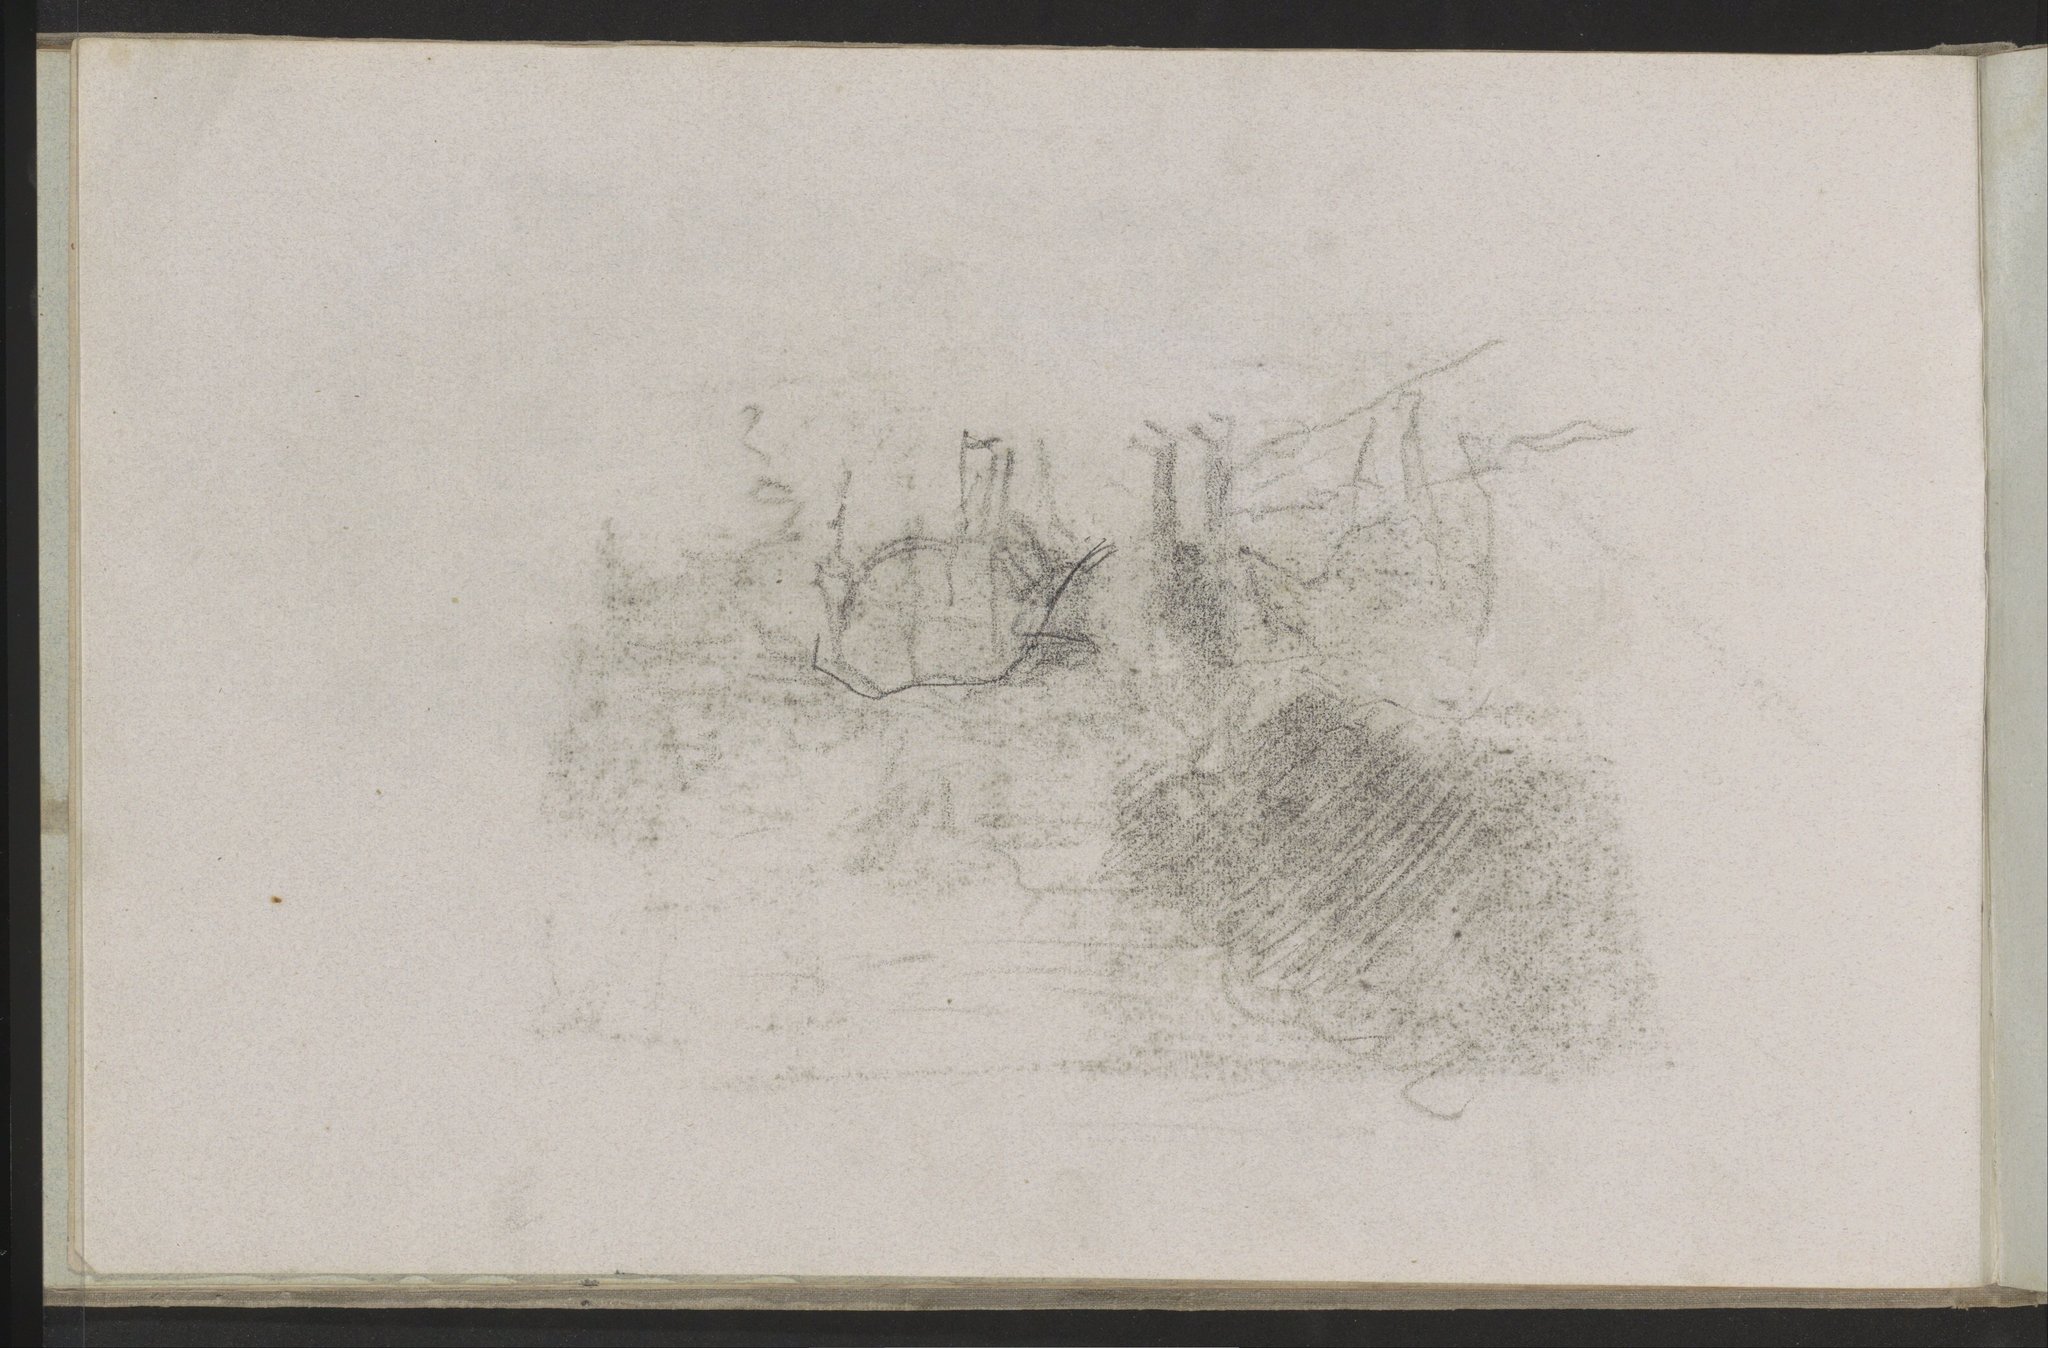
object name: sketchbook leaf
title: Dieren, vermoedelijk koeien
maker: albert neuhuys (1844-1914)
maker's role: draughtsman, painter, print maker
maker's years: 1844-1914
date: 1854-1914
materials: charcoal, paper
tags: cow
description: Blad 13 verso uit een schetsboek met 51 bladen.